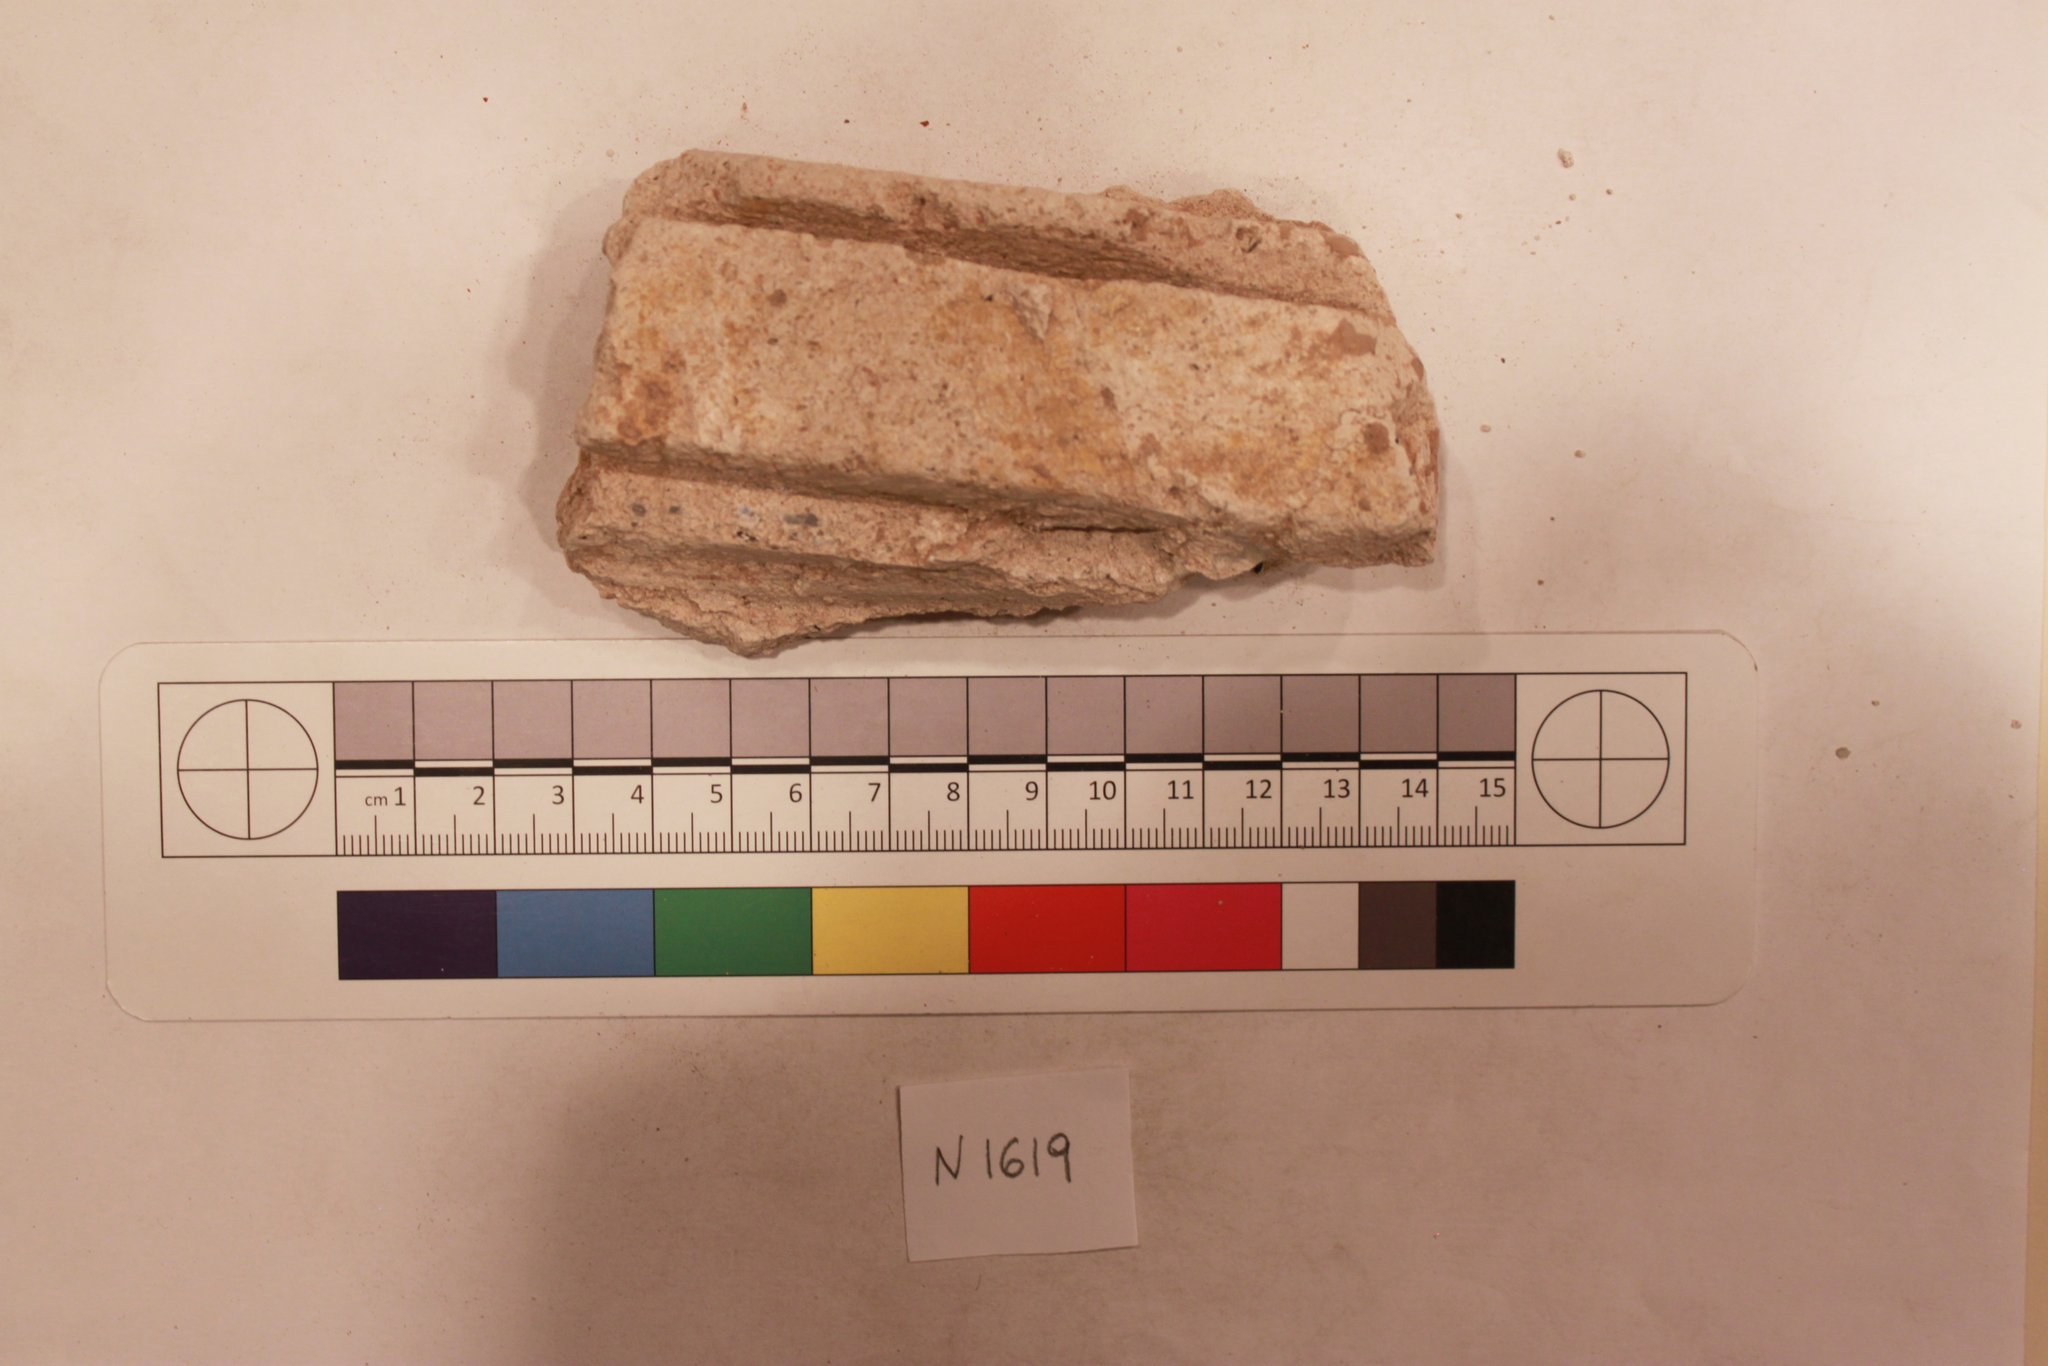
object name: fragment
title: Stucco Fragment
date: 701-1200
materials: plaster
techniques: carving, painting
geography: iran